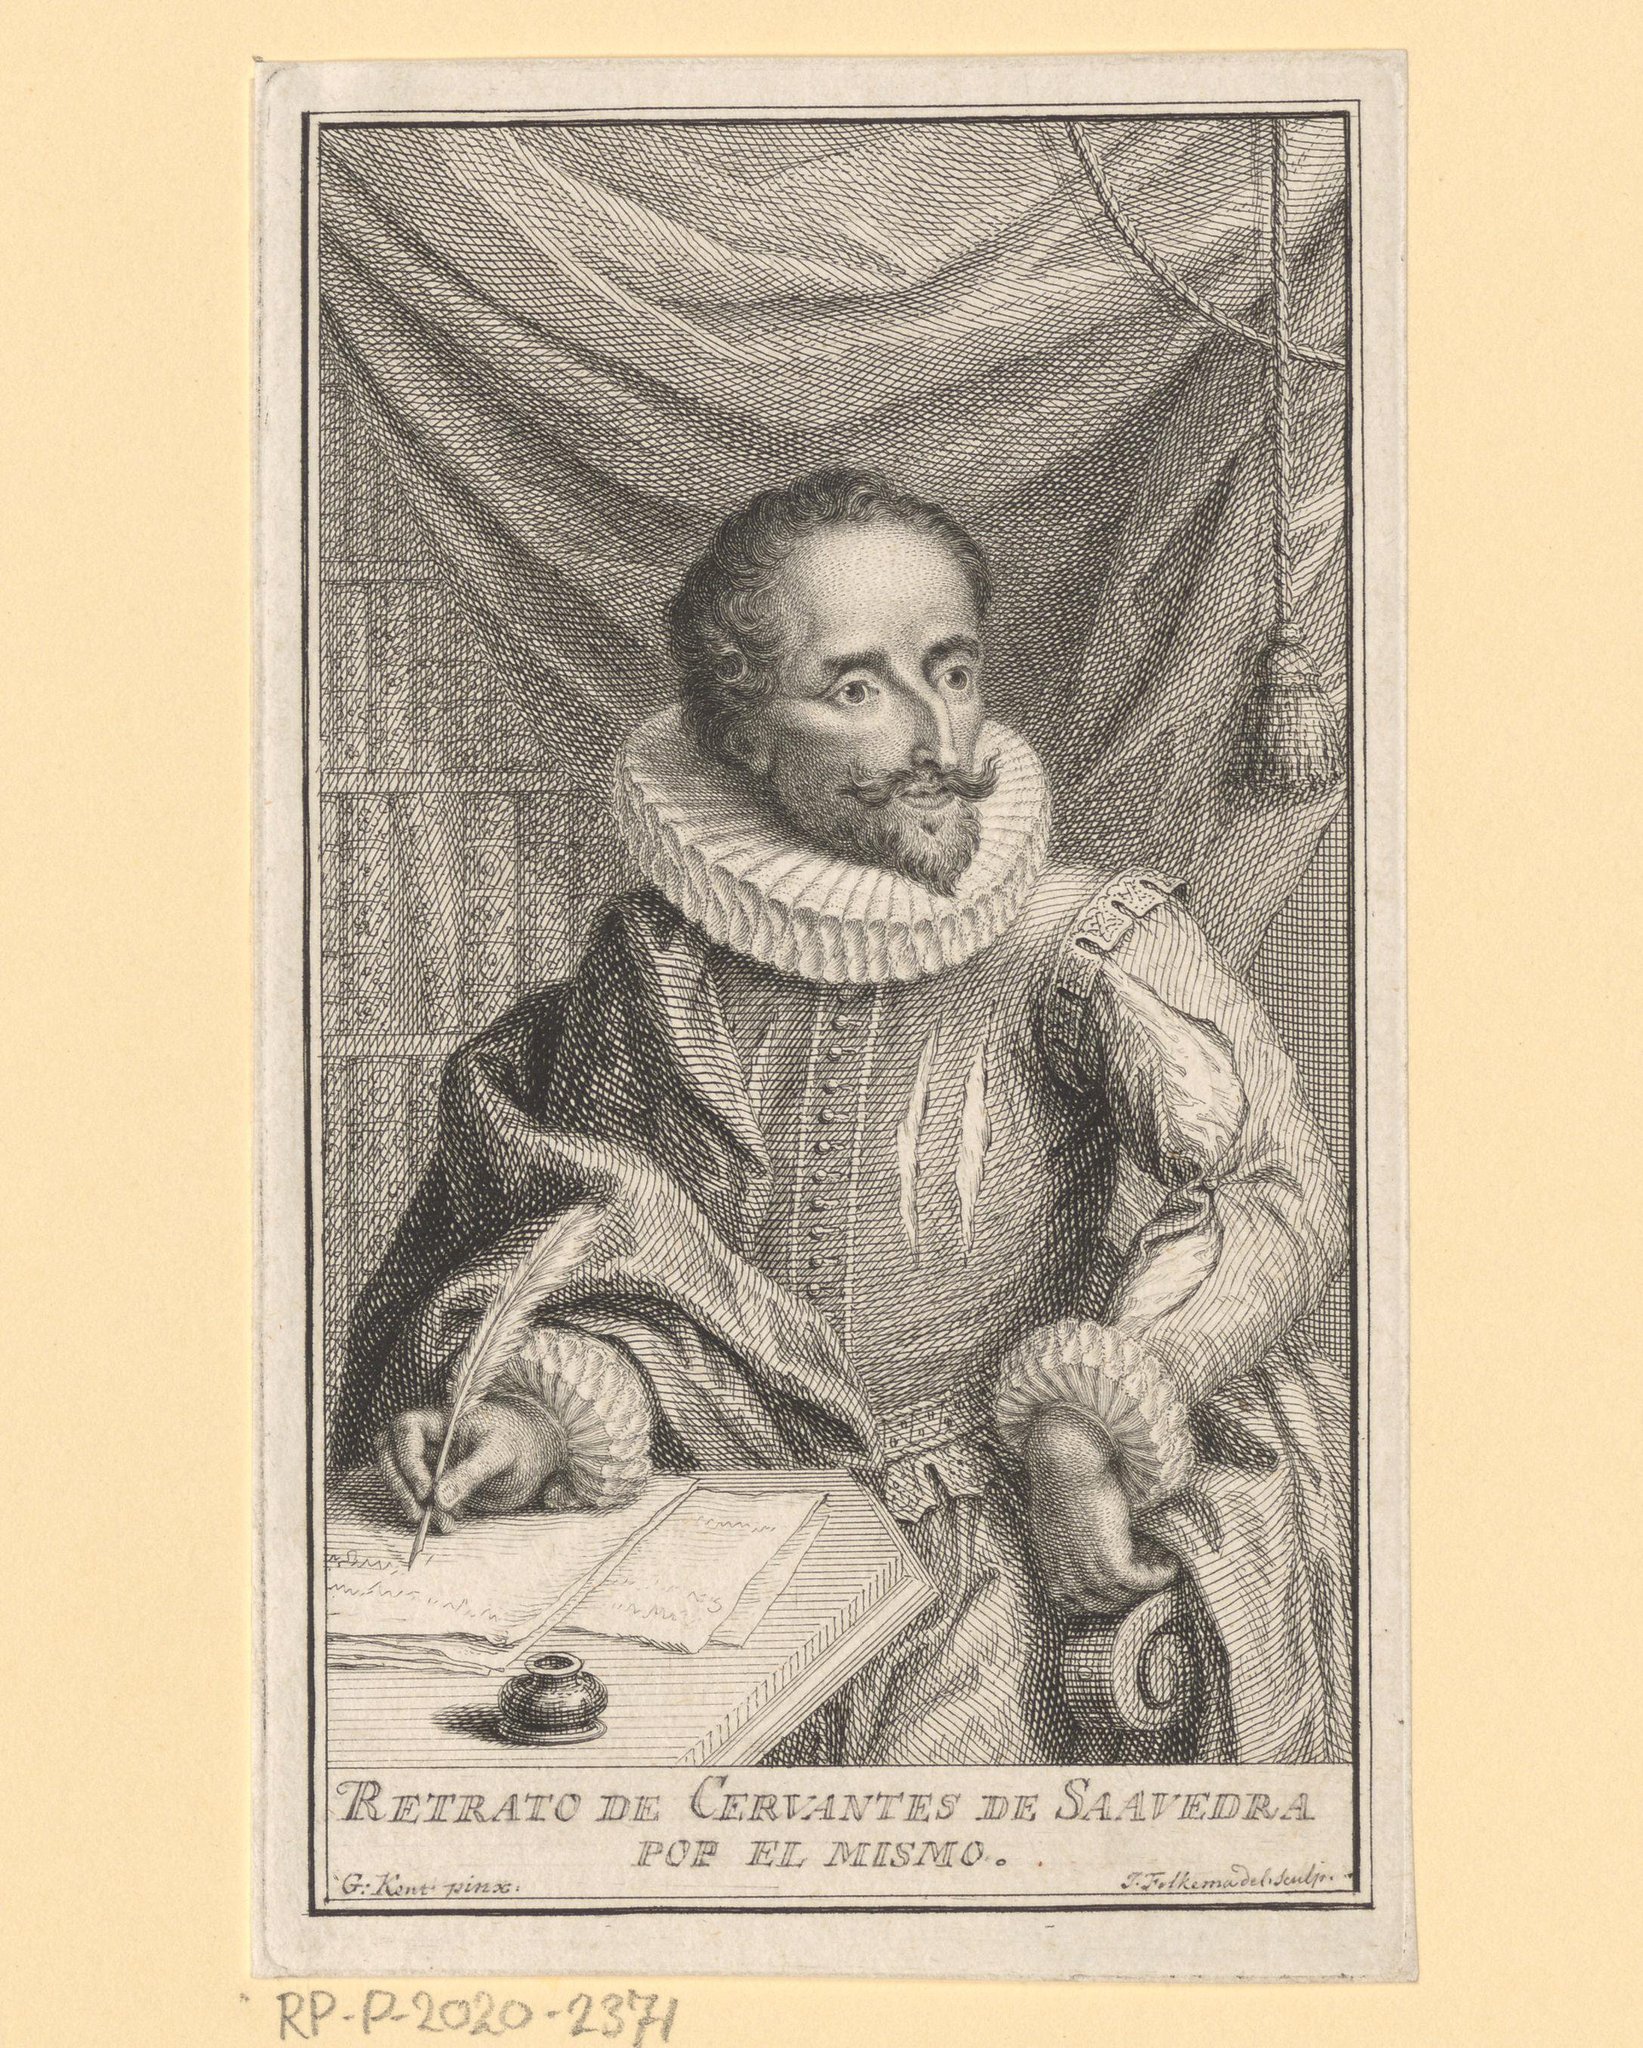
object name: print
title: Portret van Miguel de Cervantes Saavedra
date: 1768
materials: paper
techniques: engraving, etching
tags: historical persons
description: Prent waarschijnlijk uit: Cervantes Saavedra, Miguel de. Nouvelles de Michel de Cervantes Saavedra. 2 dln. Amsterdam en Leipzig: Arkstée en Mercus, 1768, dl 1.